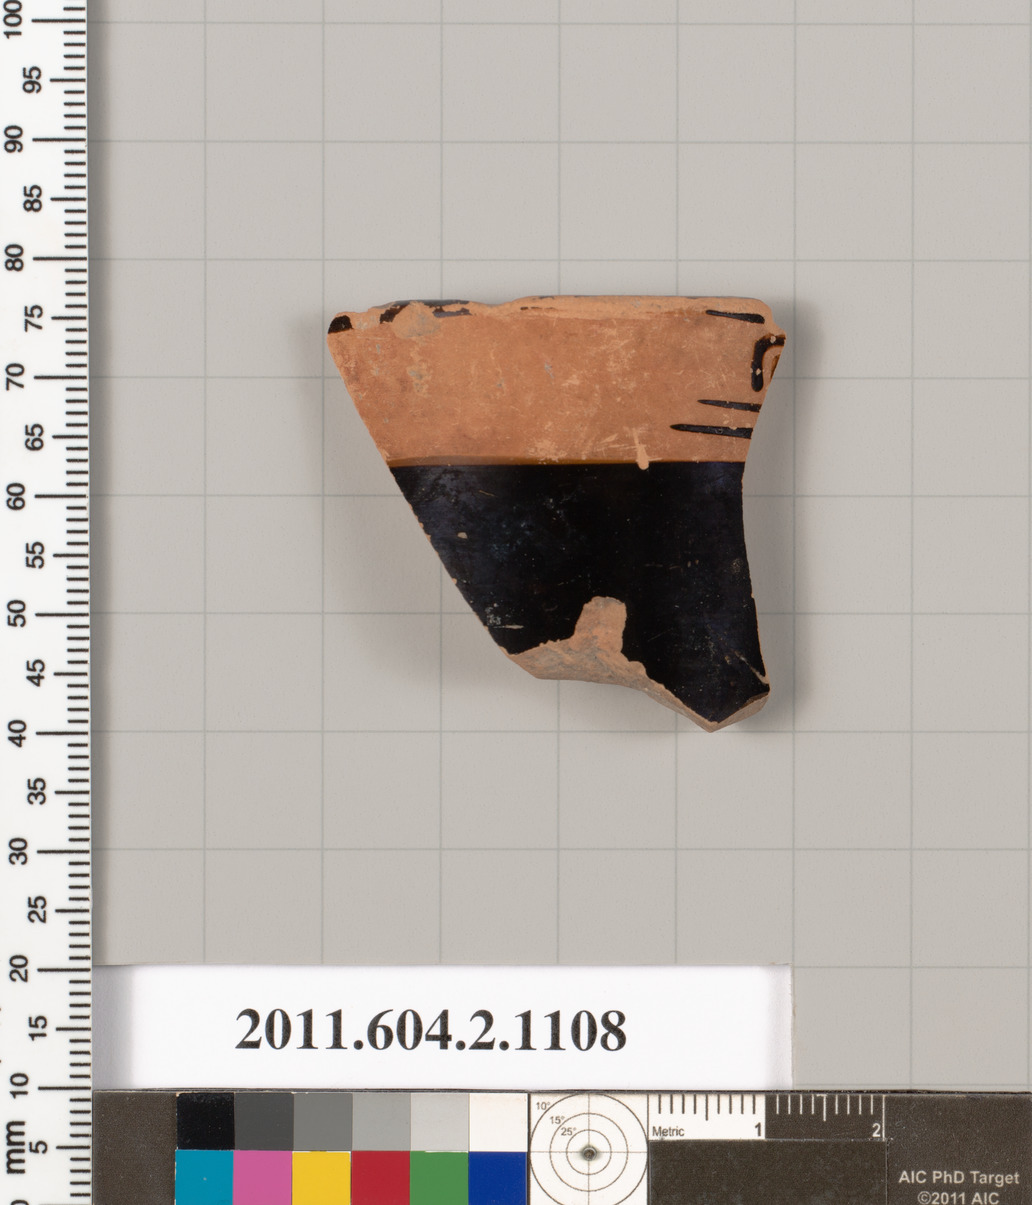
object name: lekythos fragment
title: Terracotta fragment of a lekythos (oil flask)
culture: greek, attic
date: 475-451 BCE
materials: terracotta